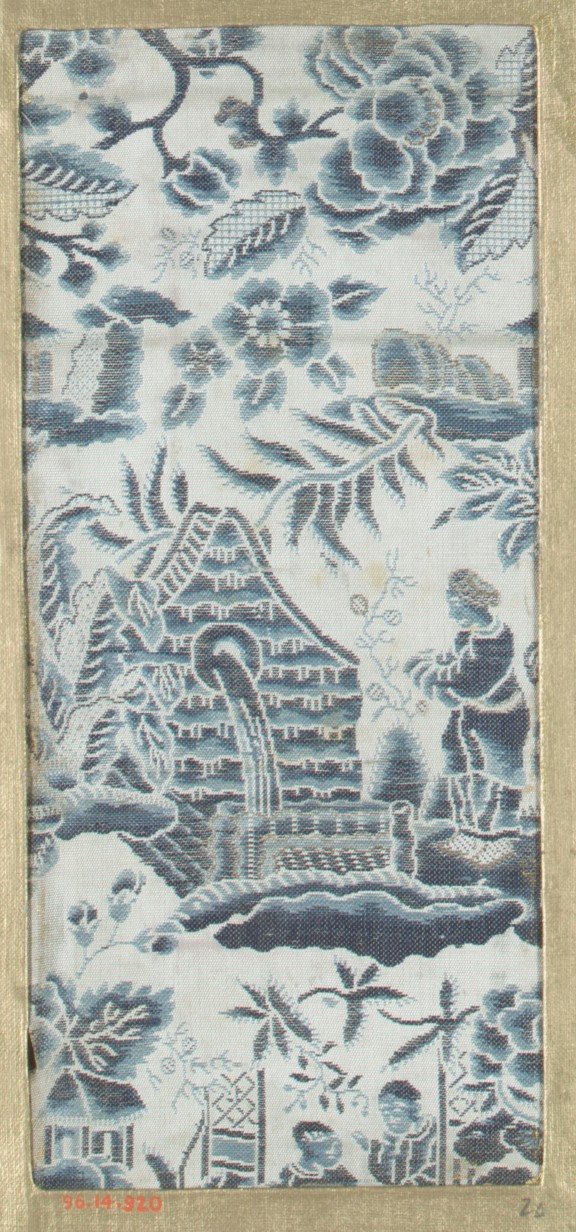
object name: piece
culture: japanese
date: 1701-1900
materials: silk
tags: houses,flowers,leaves